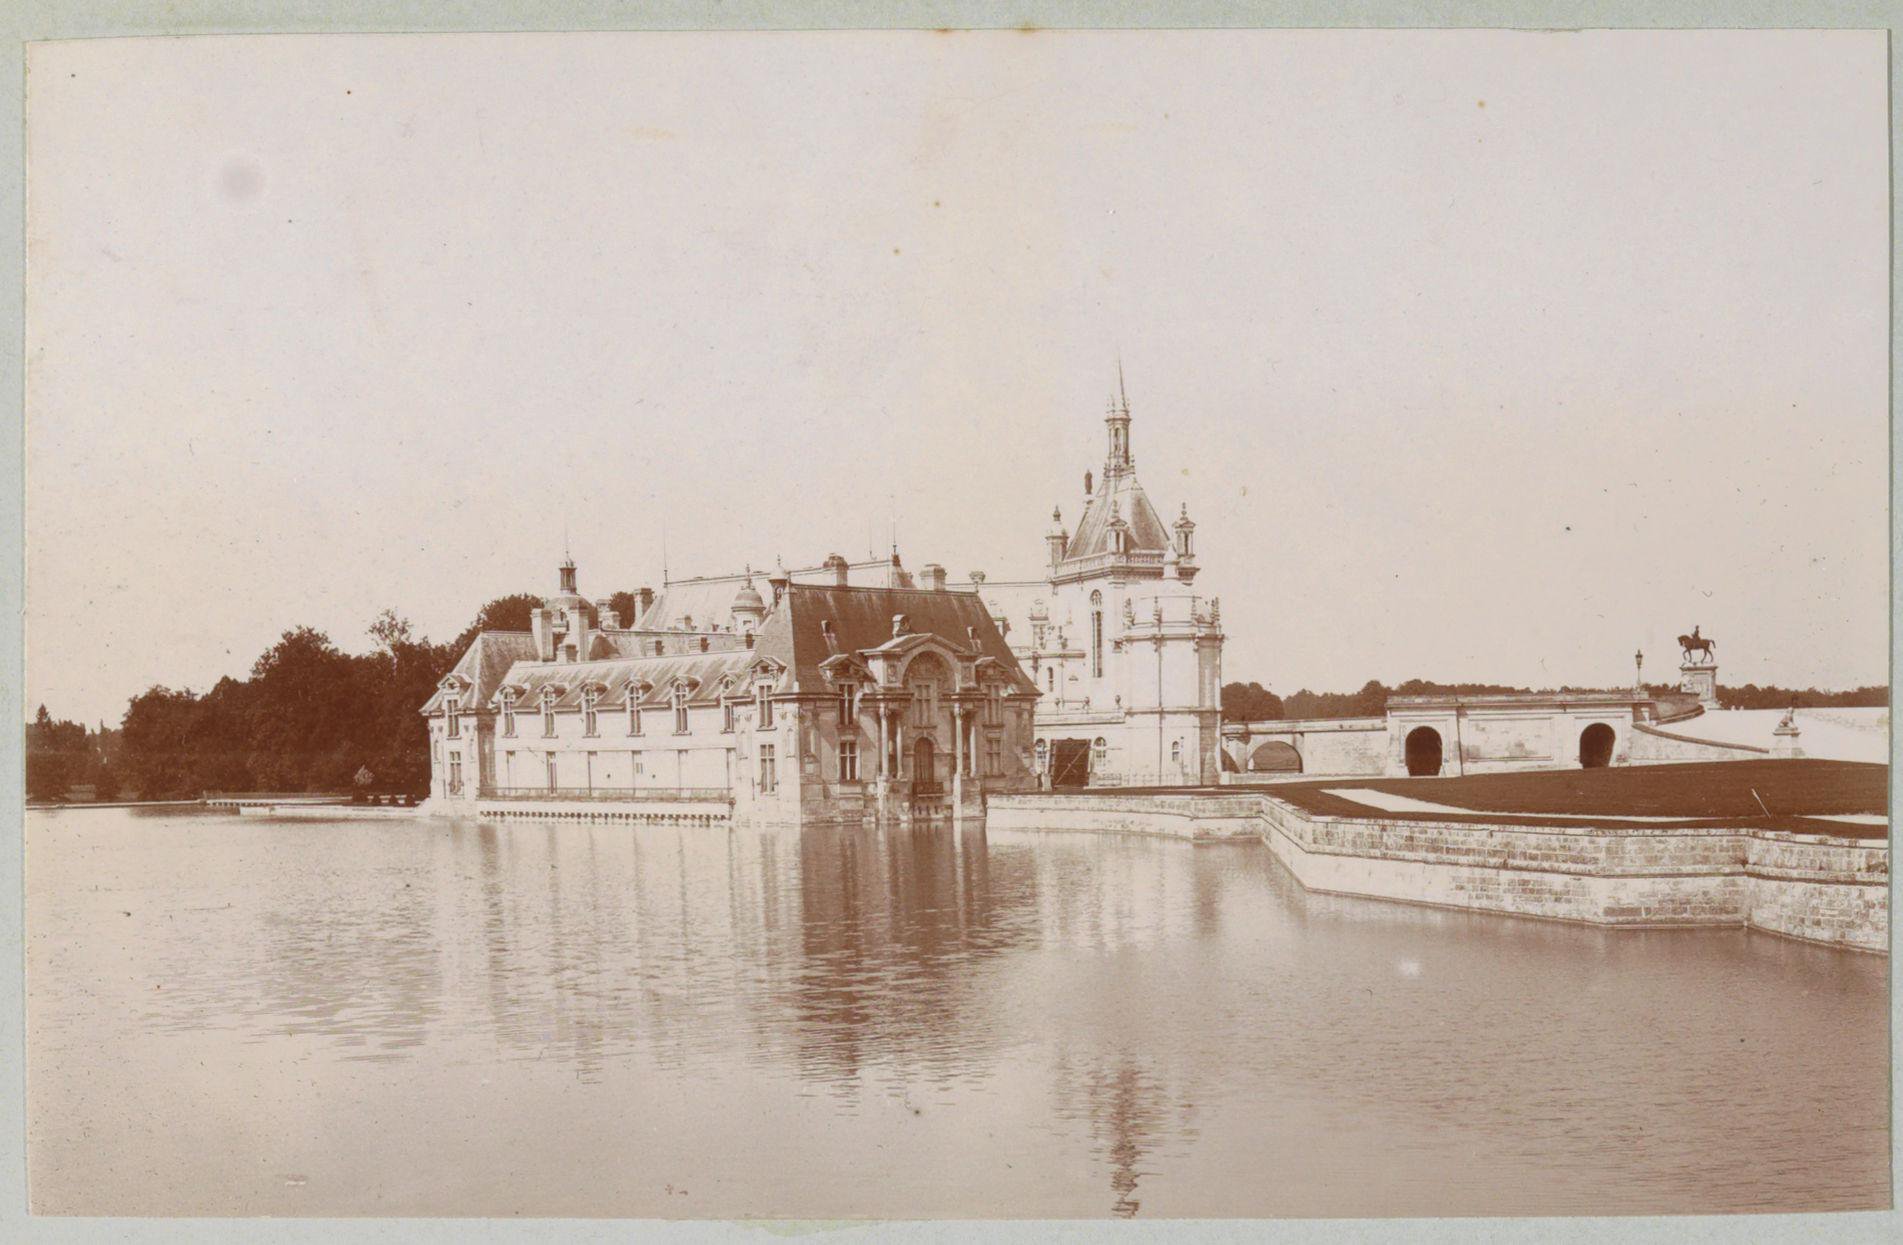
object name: photograph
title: Gezicht op het Kasteel van Chantilly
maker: delizy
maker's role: manufacturer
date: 1900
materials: paper, photographic support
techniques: gelatin silver print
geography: chantilly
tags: castle, chantilly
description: Onderdeel van Fotoalbum van een Franse amateurfotograaf met opnames van uitstapjes in Frankrijk, Spanje, België, Luxemburg en Nederland, de eerste automobielen en autoraces.